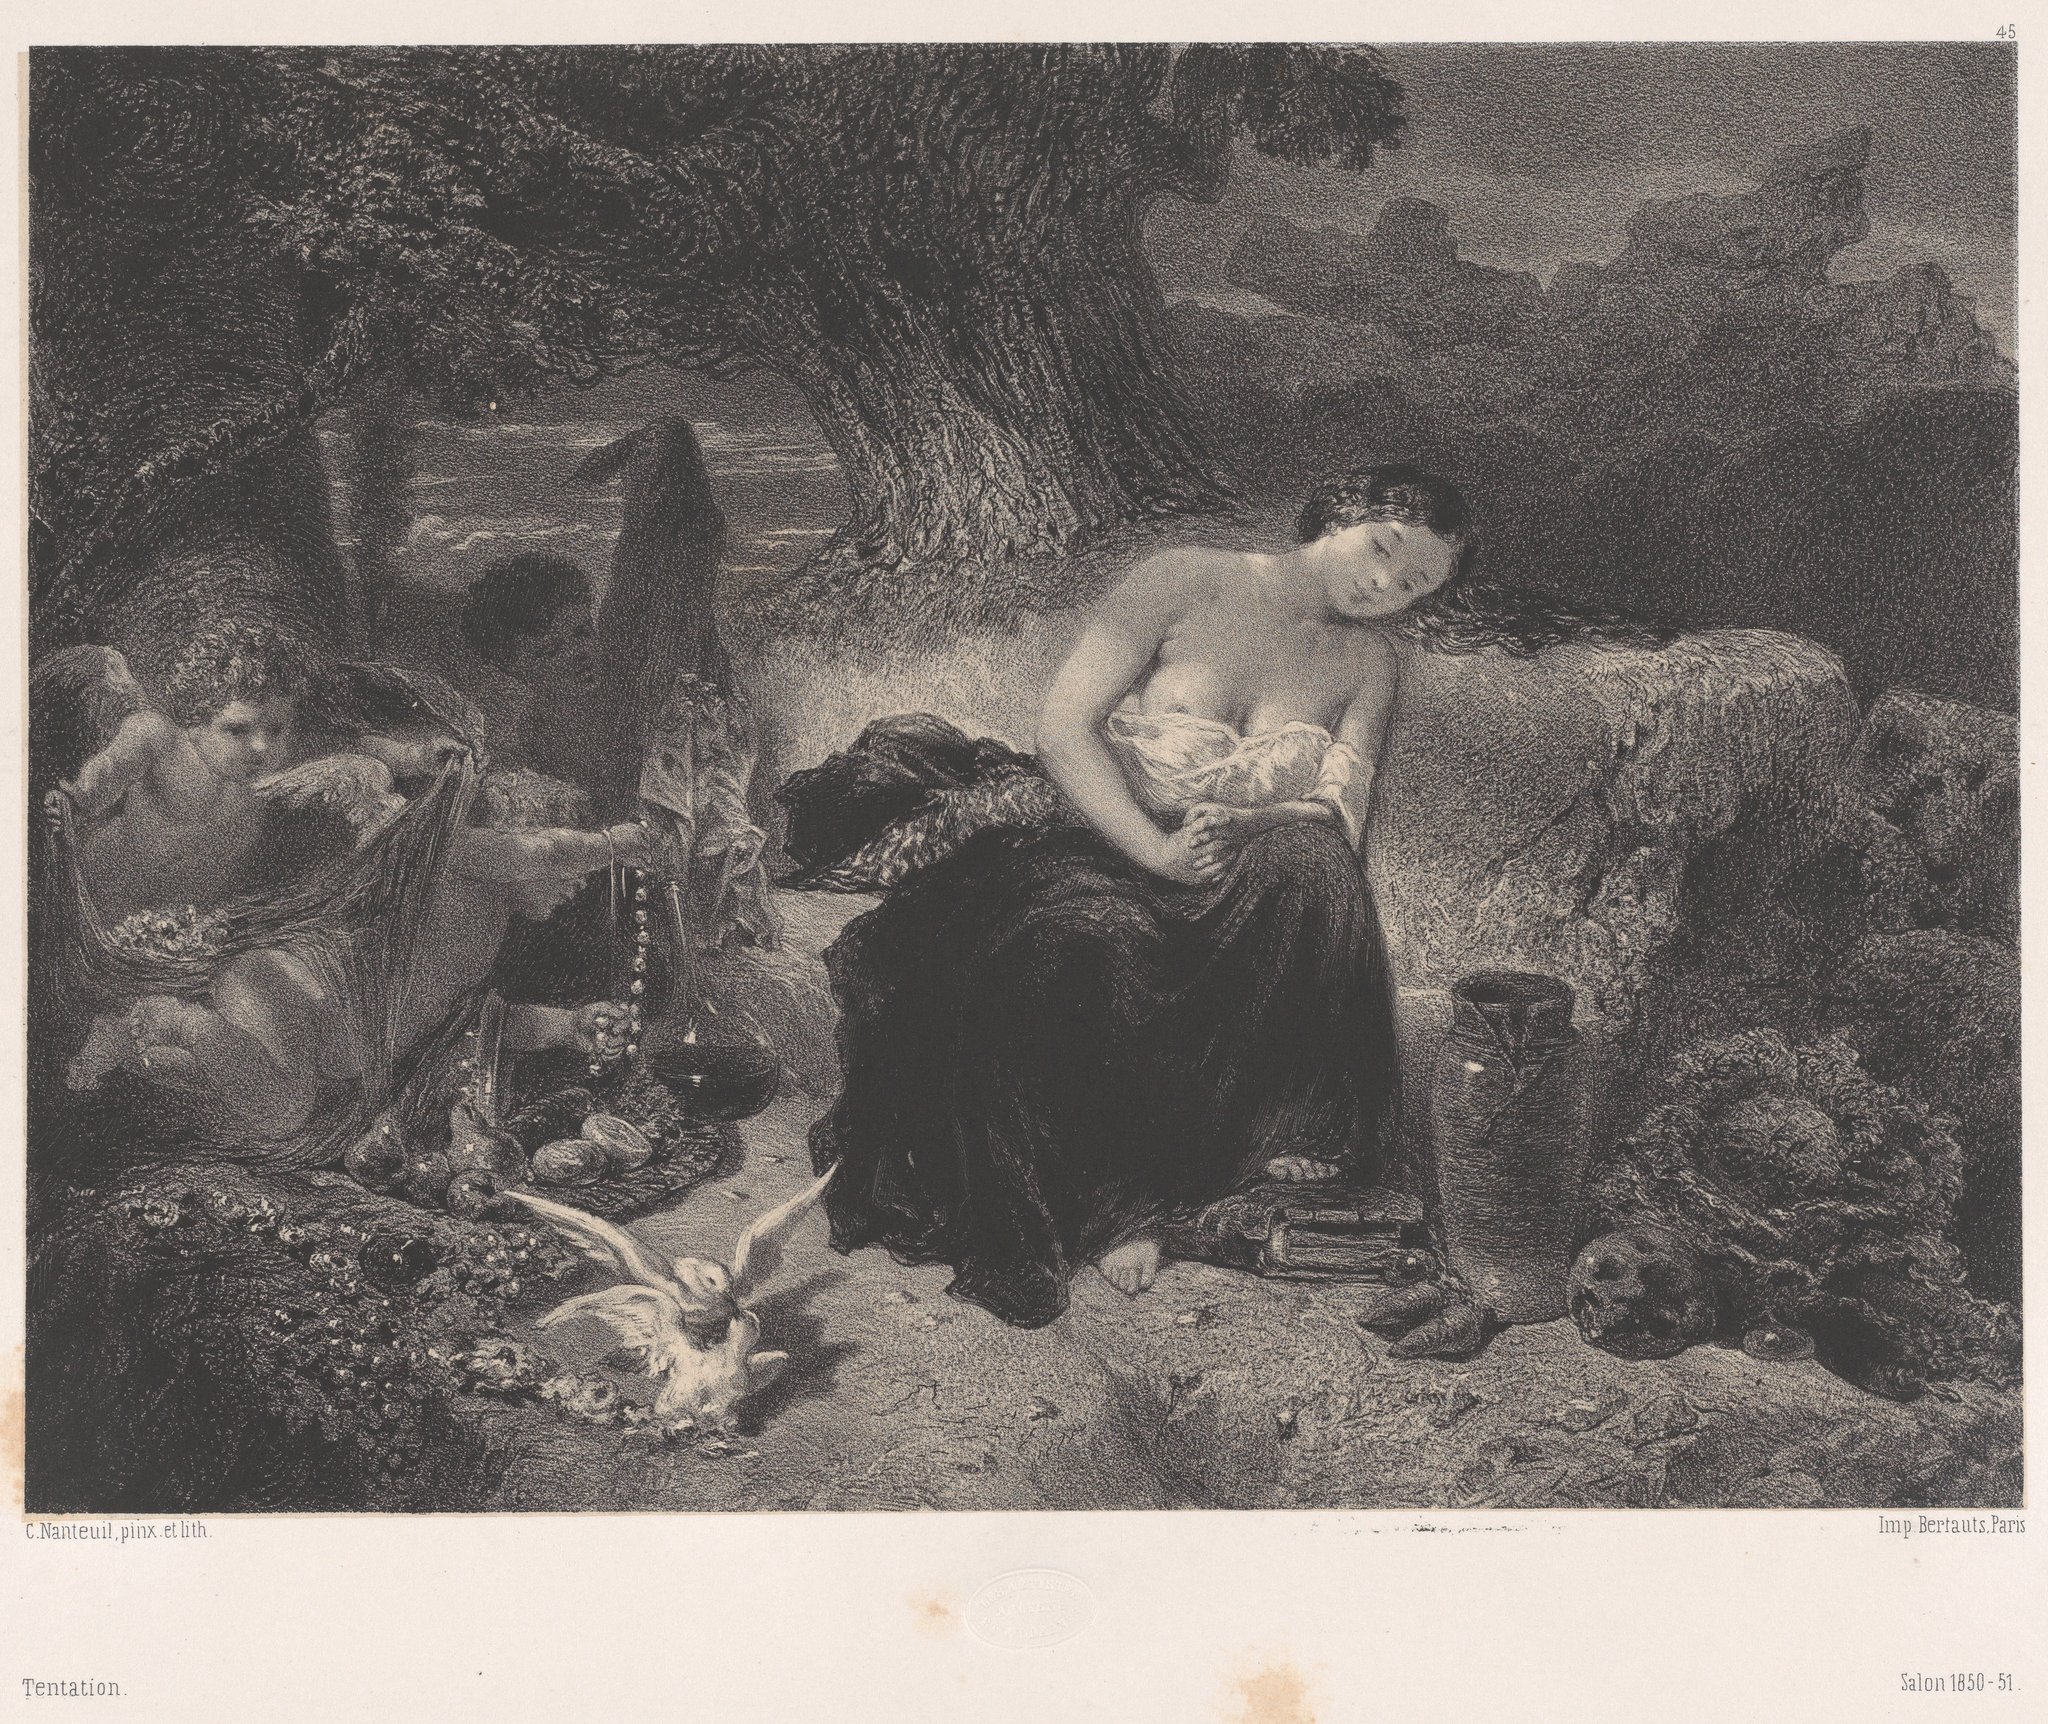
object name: print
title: Temptation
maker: célestin nanteuil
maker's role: artist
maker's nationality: french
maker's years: 1813-1873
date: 1850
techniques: lithograph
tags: women,putti